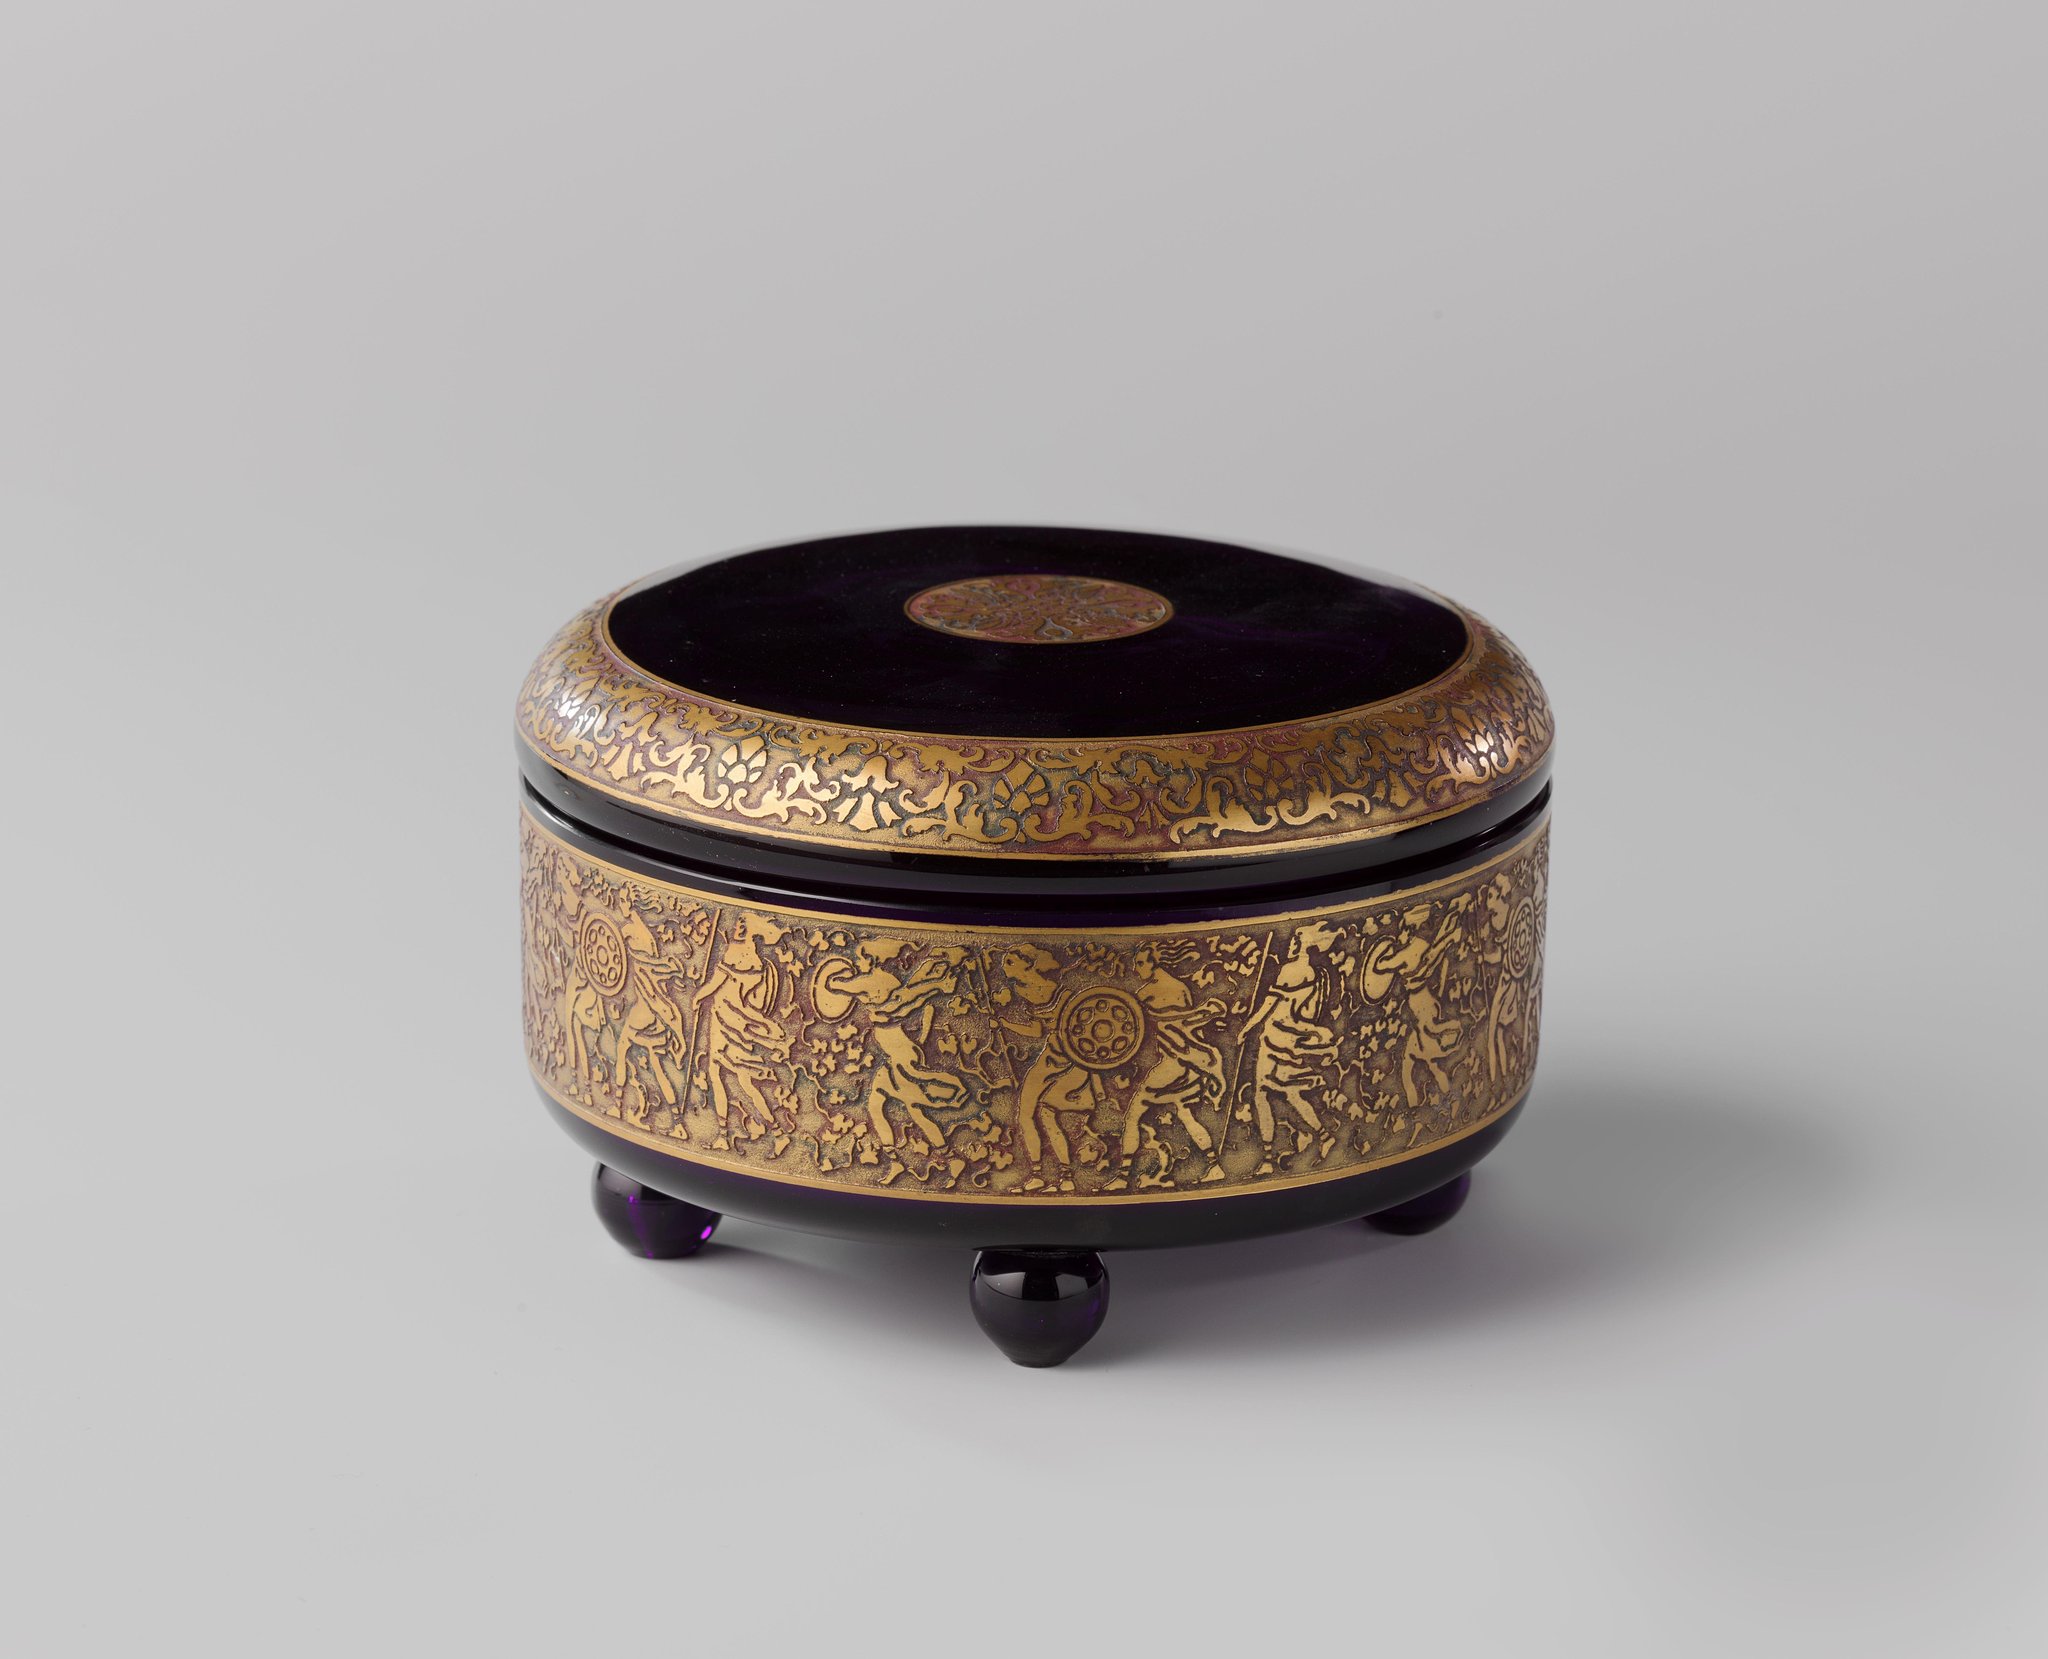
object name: lid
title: Deksel van doos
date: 1925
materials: glass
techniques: etching, gilding, glassblowing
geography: karlovy vary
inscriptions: number: ‘14’, signature: ‘Moser Karlsbad’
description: In het midden van het deksel een medaillon, op de rand een band met palmetten en ranken.